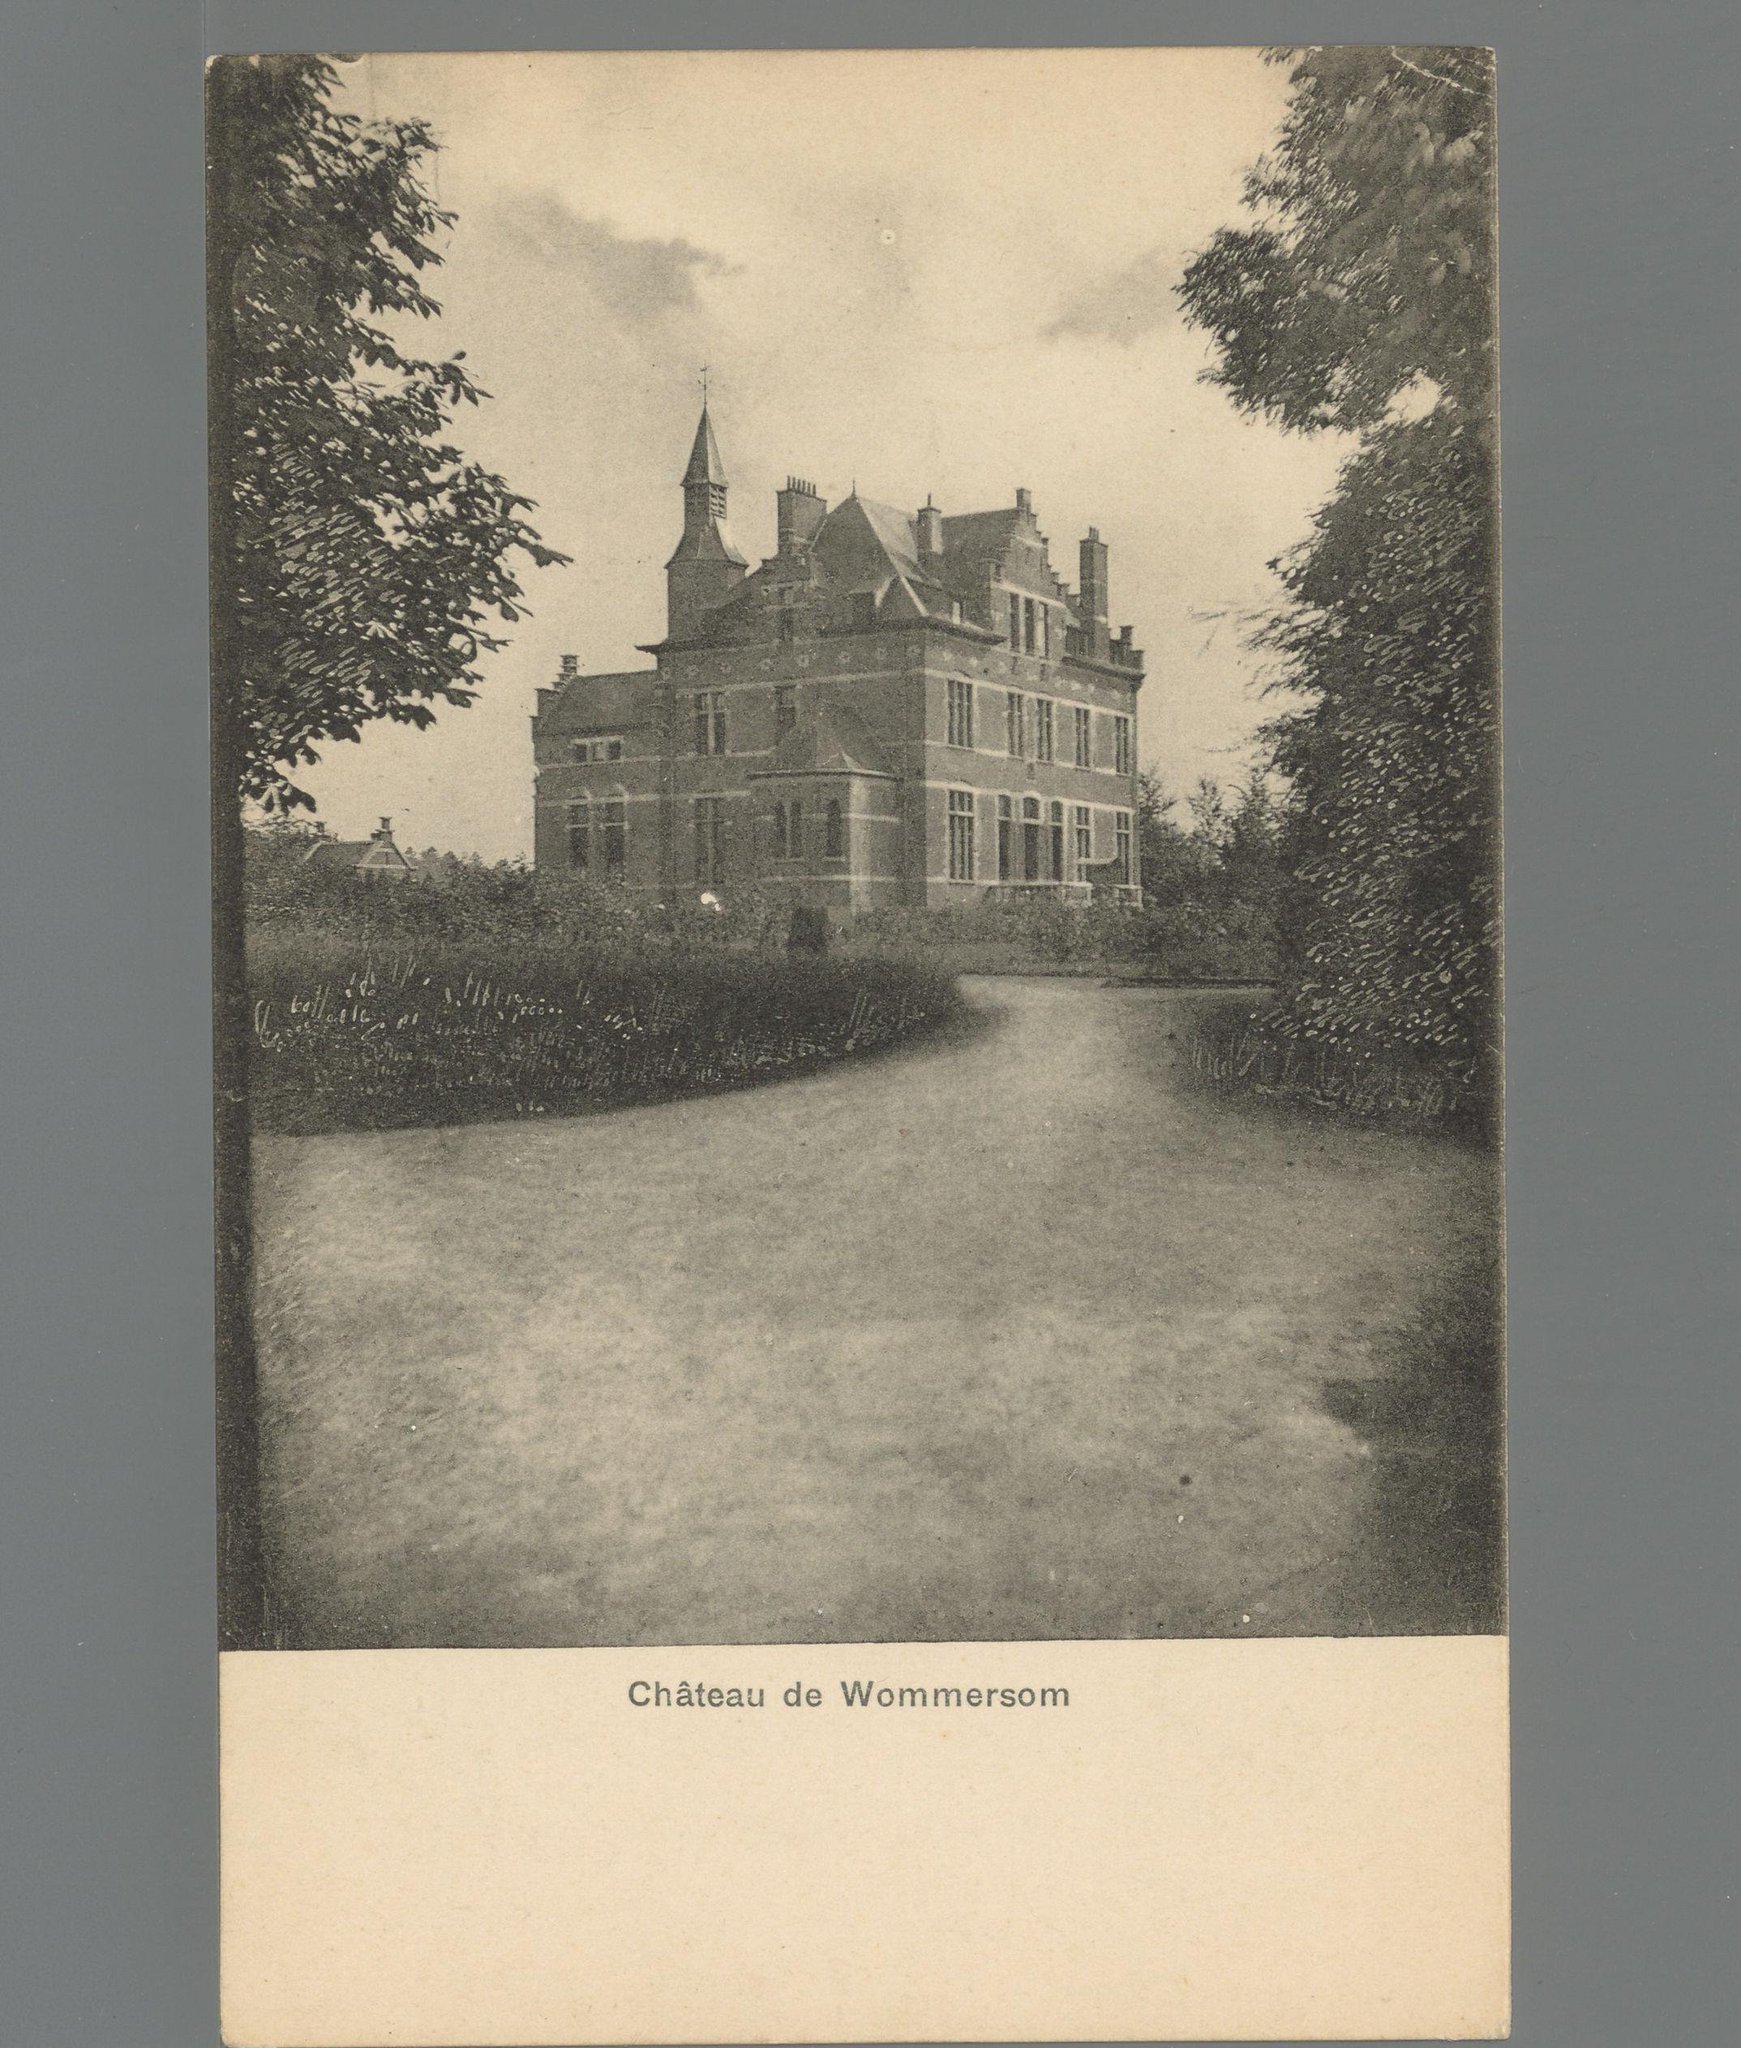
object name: ansichtkaart, prentbriefkaart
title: Château de Wommersom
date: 1906-1930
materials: cardboard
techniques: photograph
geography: wommersom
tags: park, castle